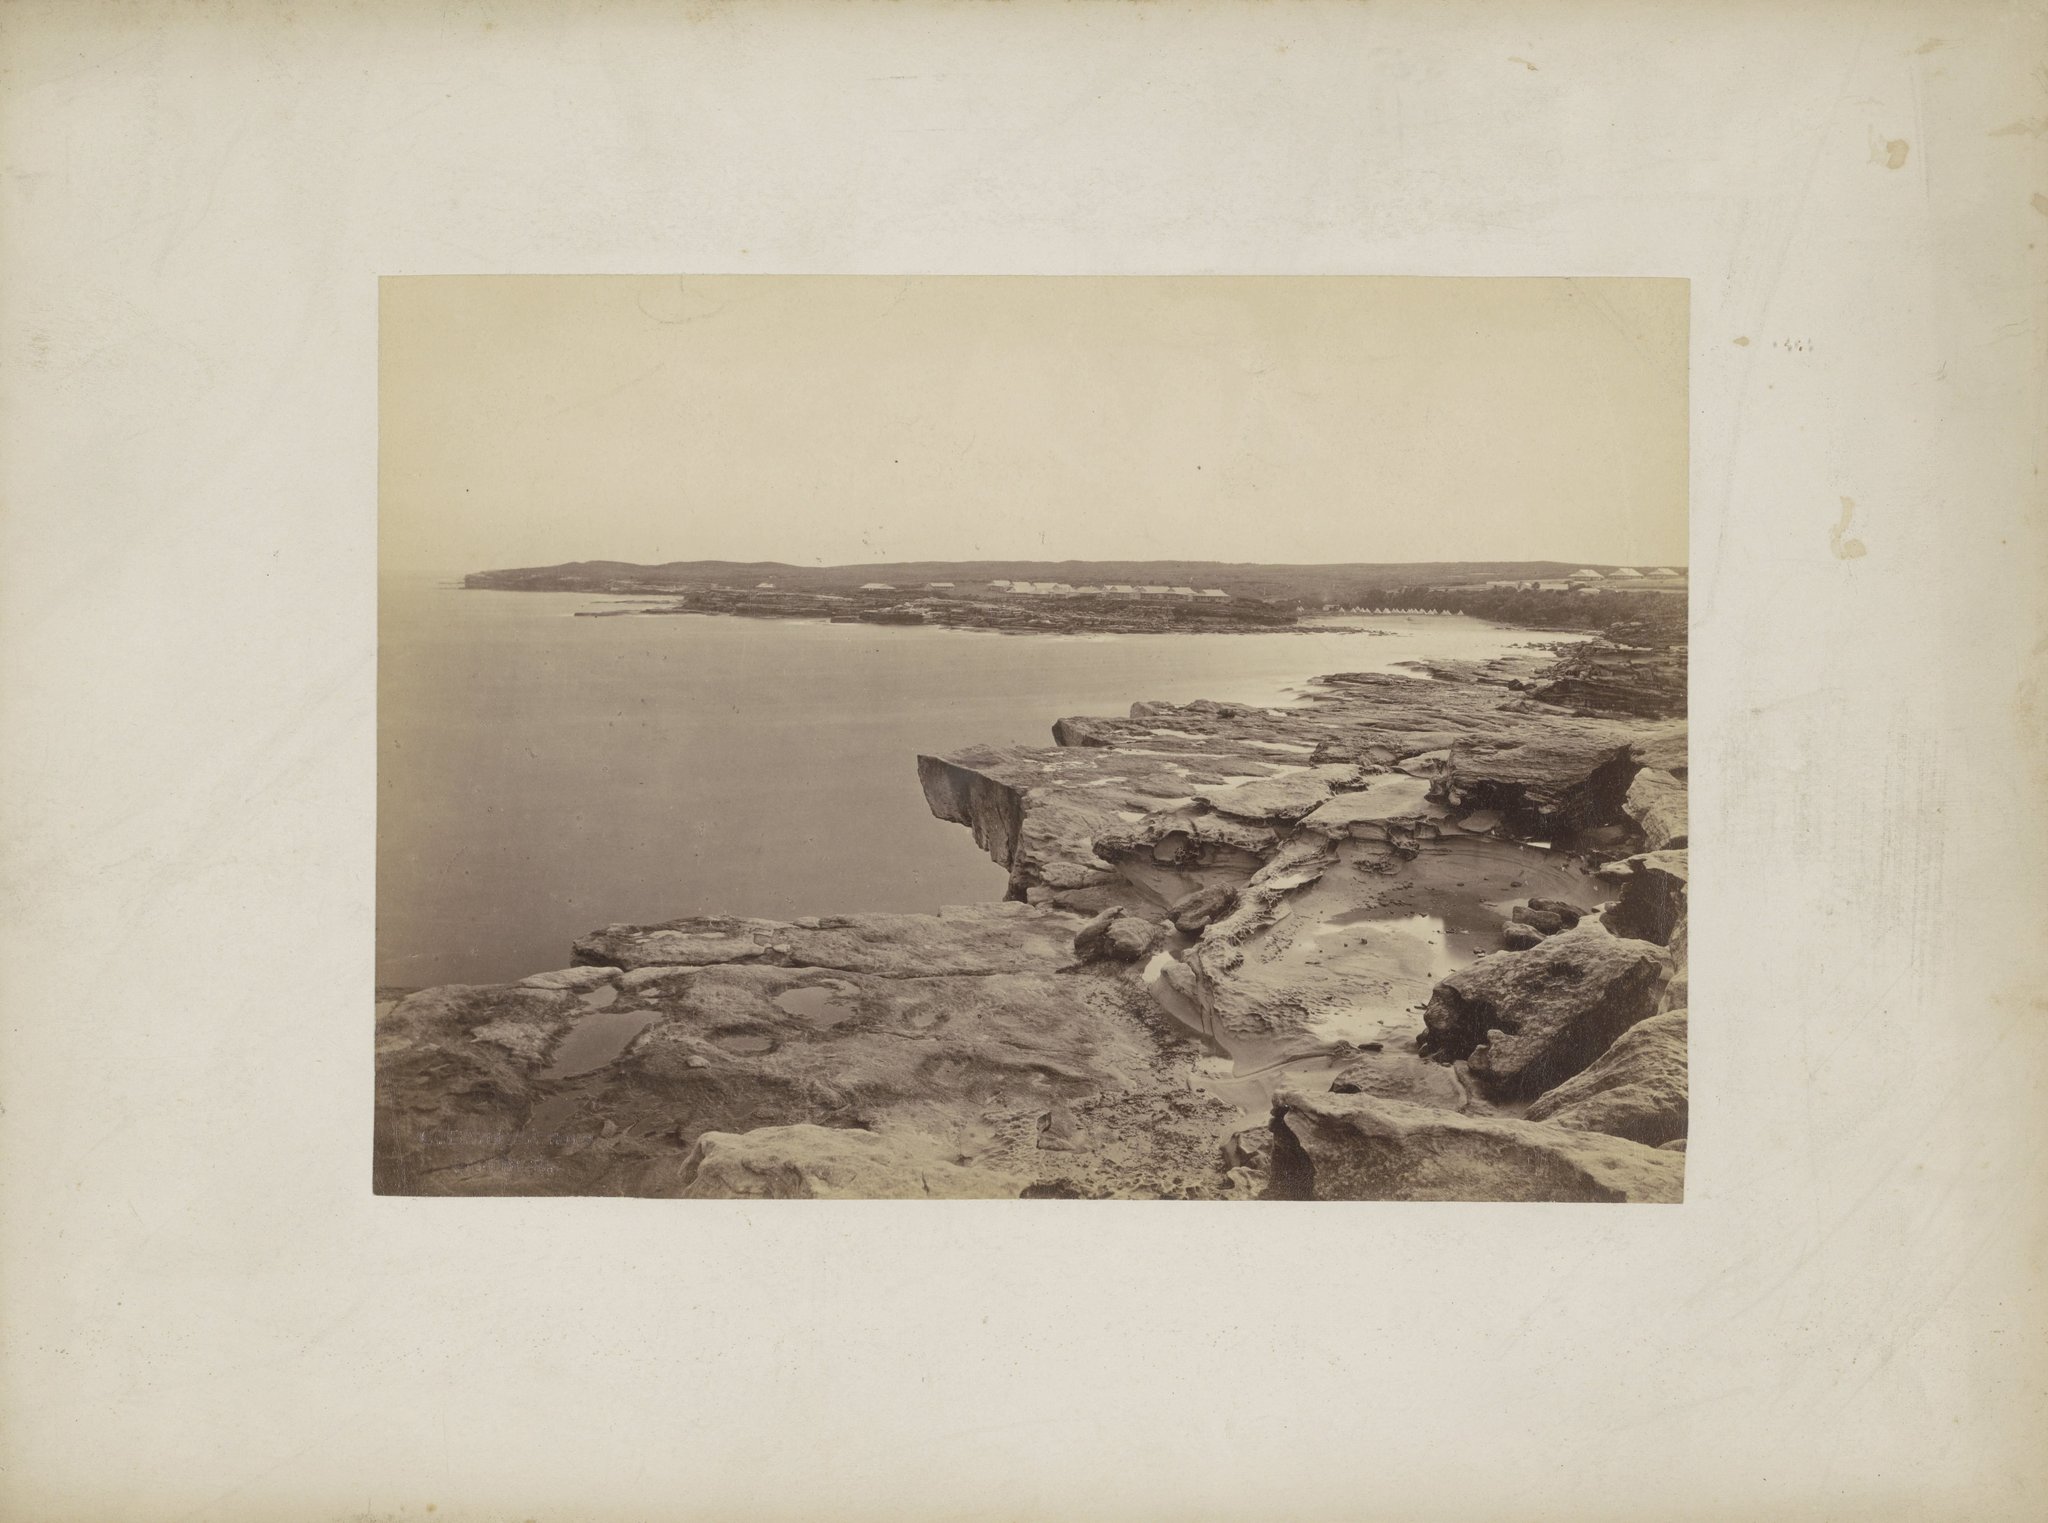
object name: album leaf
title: Gezicht op een baai met rotsen, vermoedelijk in de buurt van Sydney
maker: charles bayliss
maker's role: fotograaf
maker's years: 1850-1897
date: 1890-1910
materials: cardboard, paper, photographic support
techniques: albumen print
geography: sydney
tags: gulf, bay (+ landscape with figures, staffage), rock-formations, coast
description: Onderdeel van Reisalbum met foto's van bezienswaardigheden in Sydney.